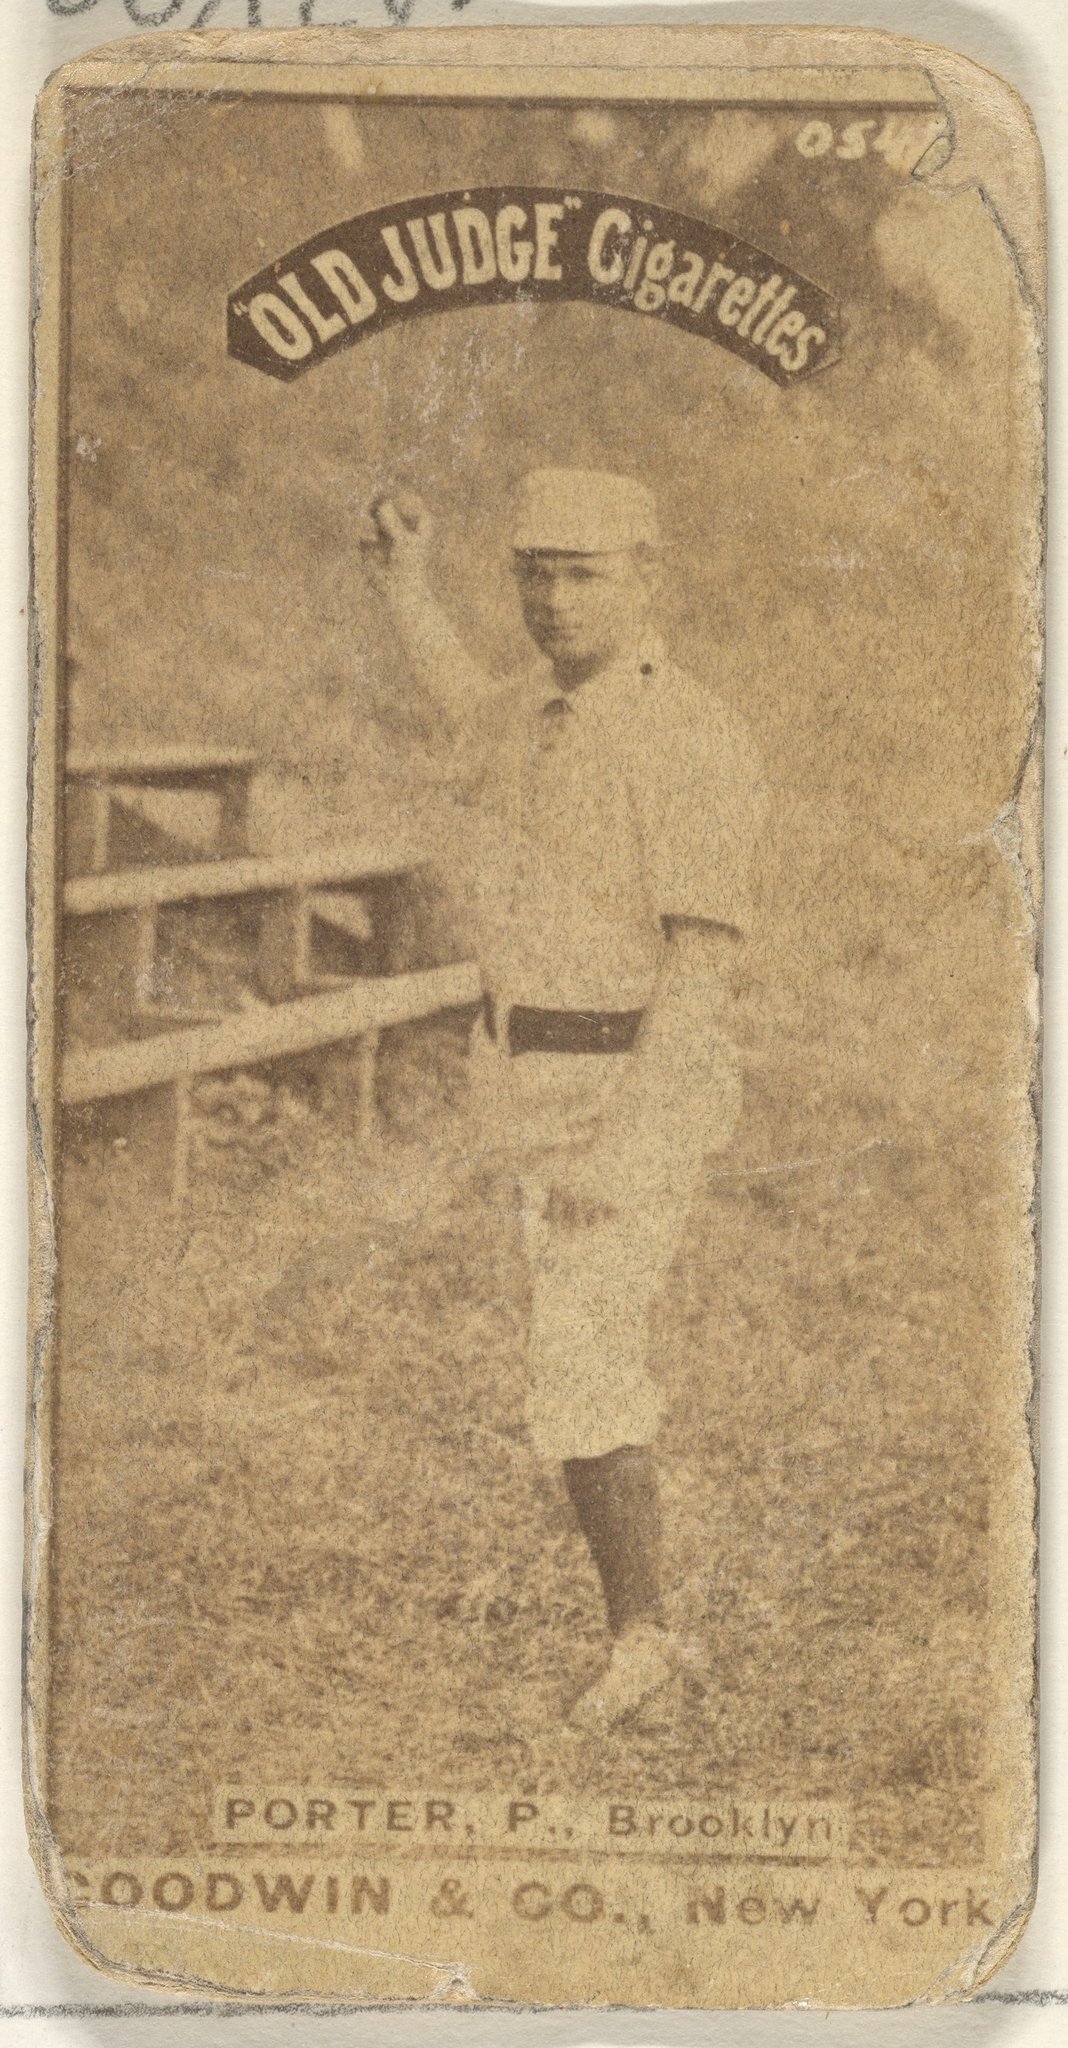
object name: baseball card, photograph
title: Porter, Pitcher, Brooklyn, from the Old Judge series (N172) for Old Judge Cigarettes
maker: goodwin & company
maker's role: publisher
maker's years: 1850-1950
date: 1887-1890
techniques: albumen silver print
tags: men,portraits,baseball,athletes